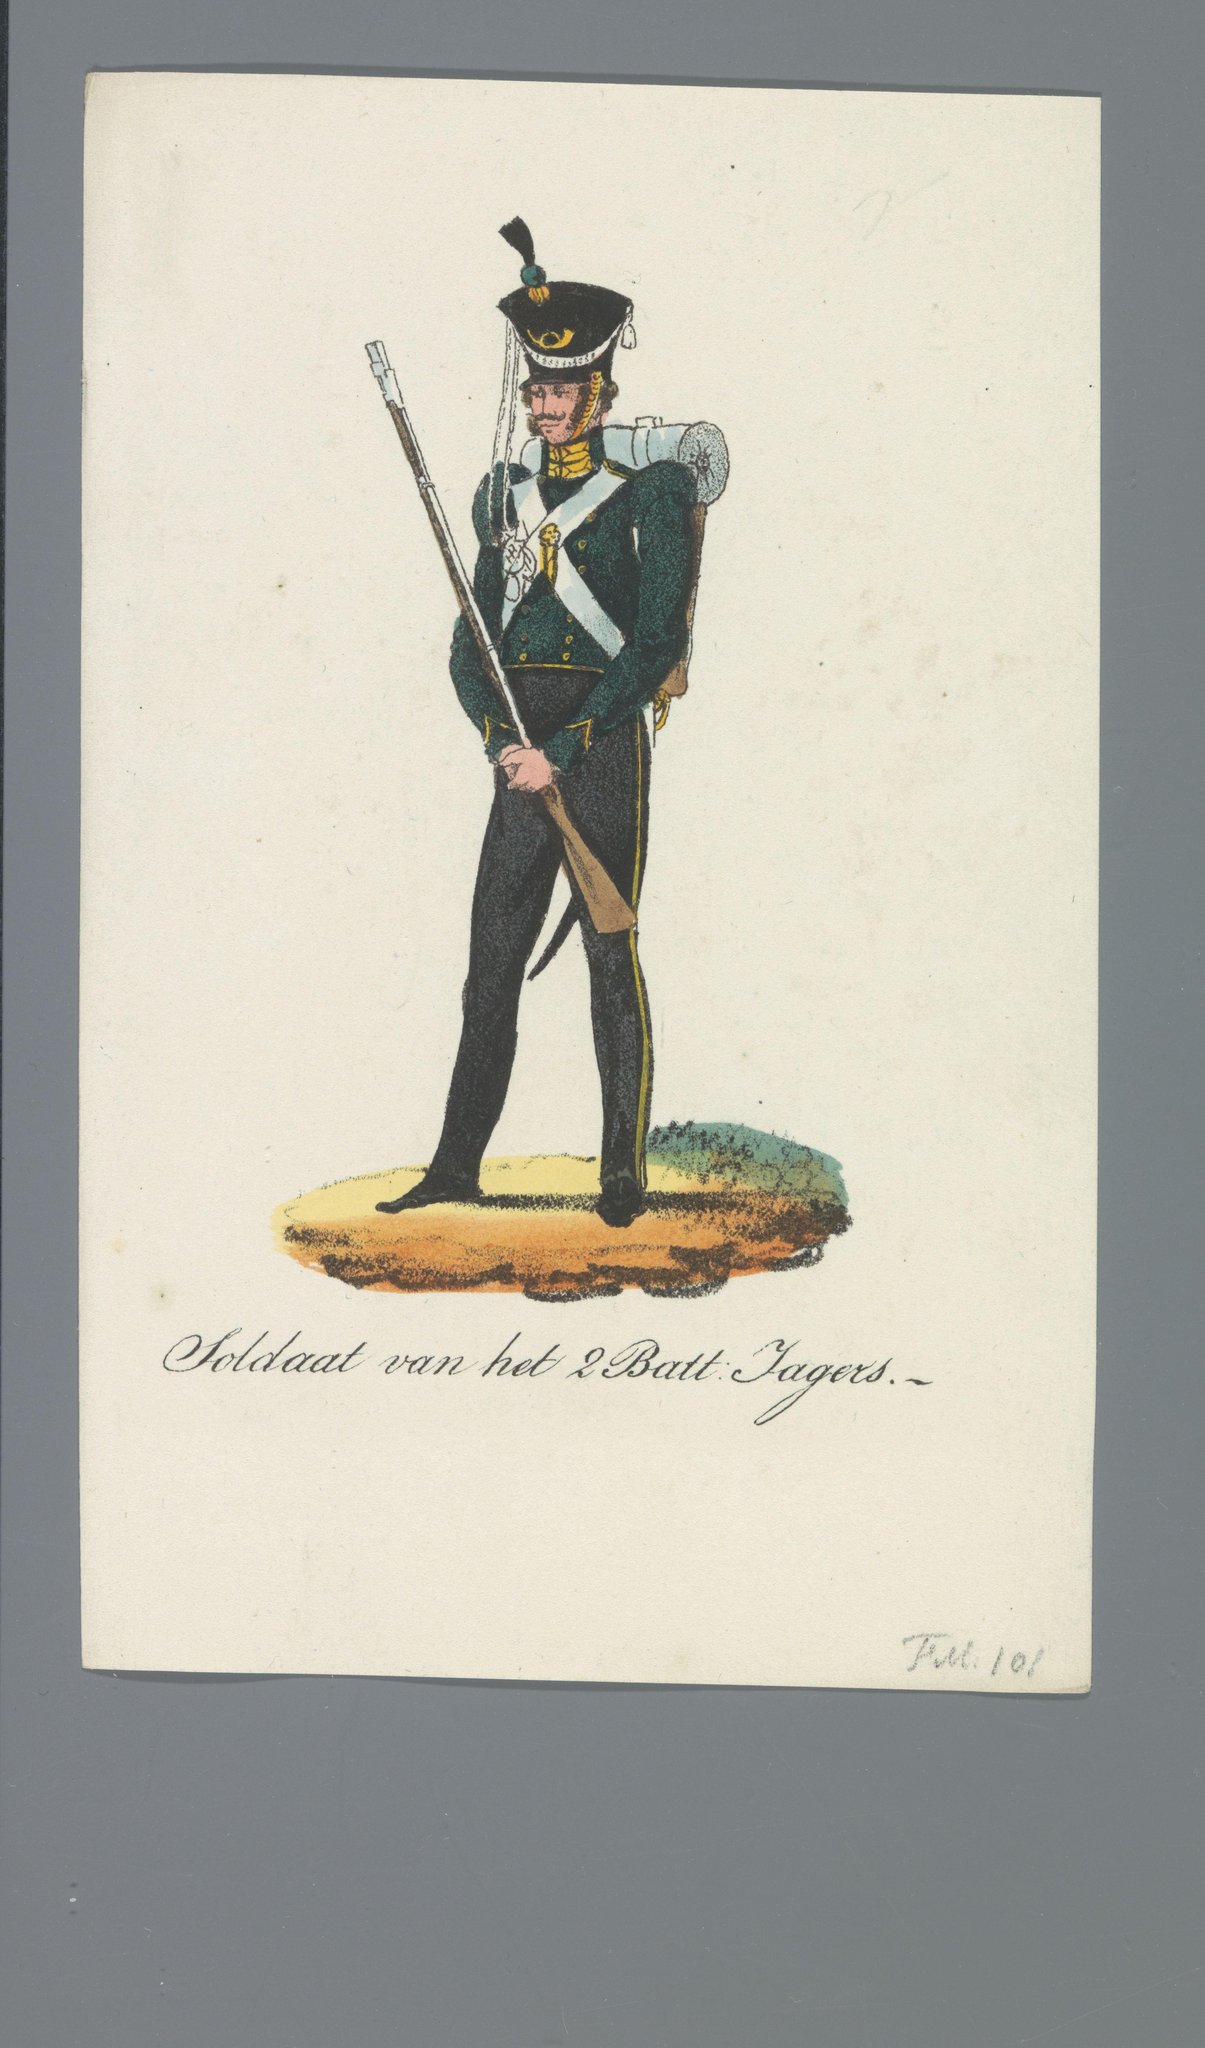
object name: costume print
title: Soldaat van het 2 Batt. Jagers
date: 1835-1850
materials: paper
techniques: hand coloring, lithograph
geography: utrecht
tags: (military) uniforms, clothes, costume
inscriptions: collector's mark: Lugt 2228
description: Een soldaat van het 2e Bataljon Jagers, te voet. Onderdeel van een serie van 157 losse bladen met Nederlandse militaire uniformen in de jaren 1830-1832.